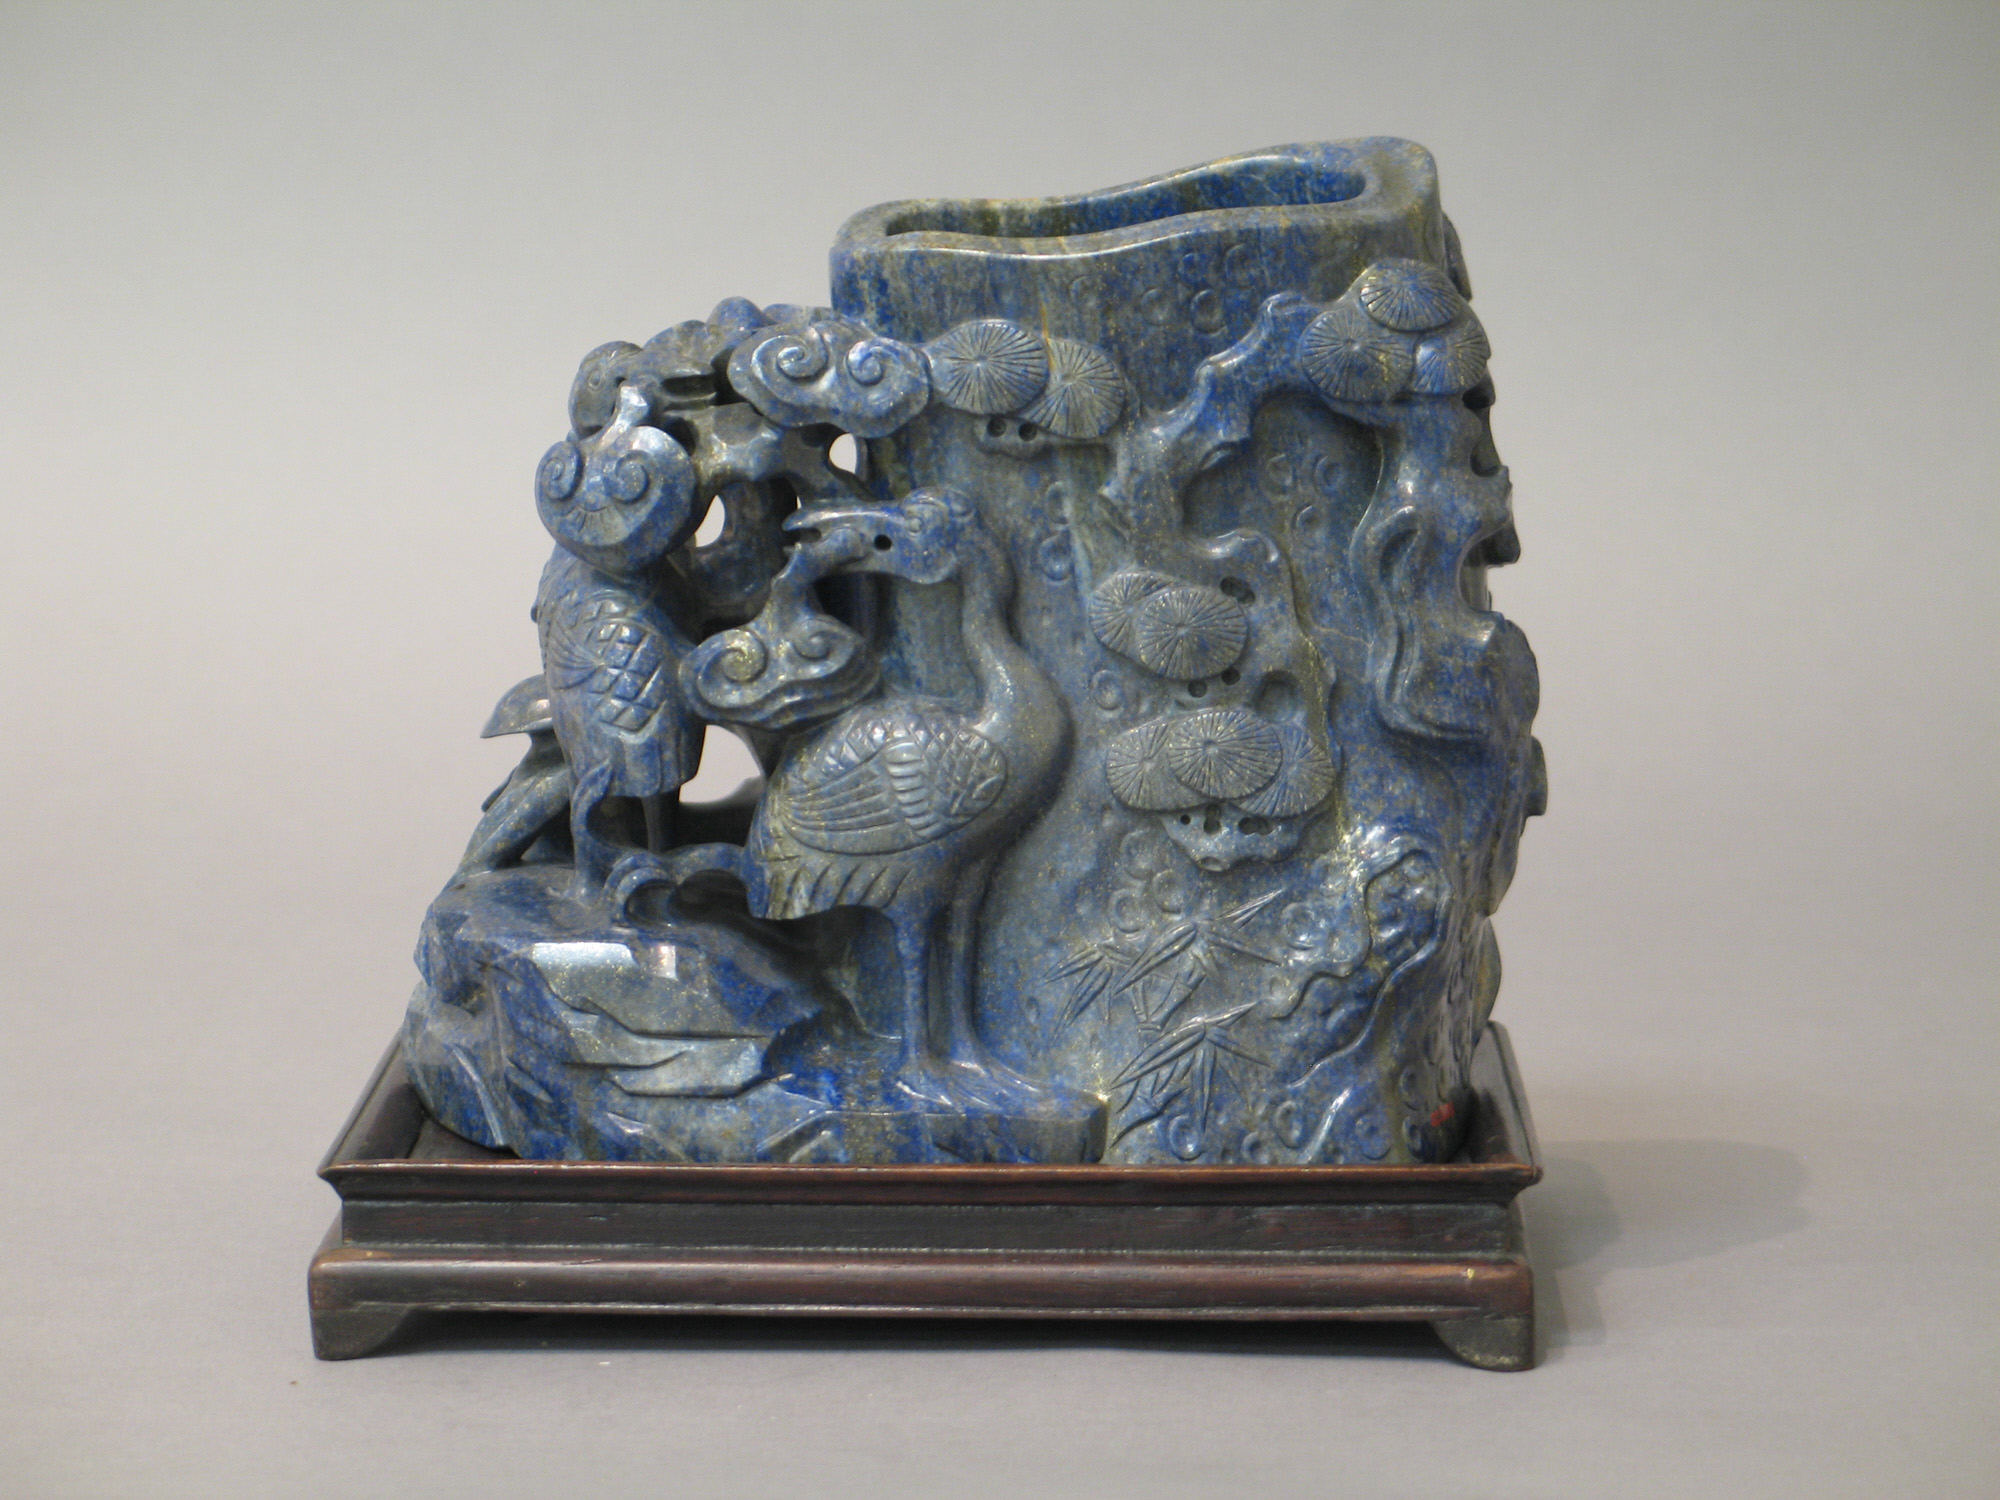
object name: carving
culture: chinese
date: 1701-1800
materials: lapis lazuli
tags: cranes